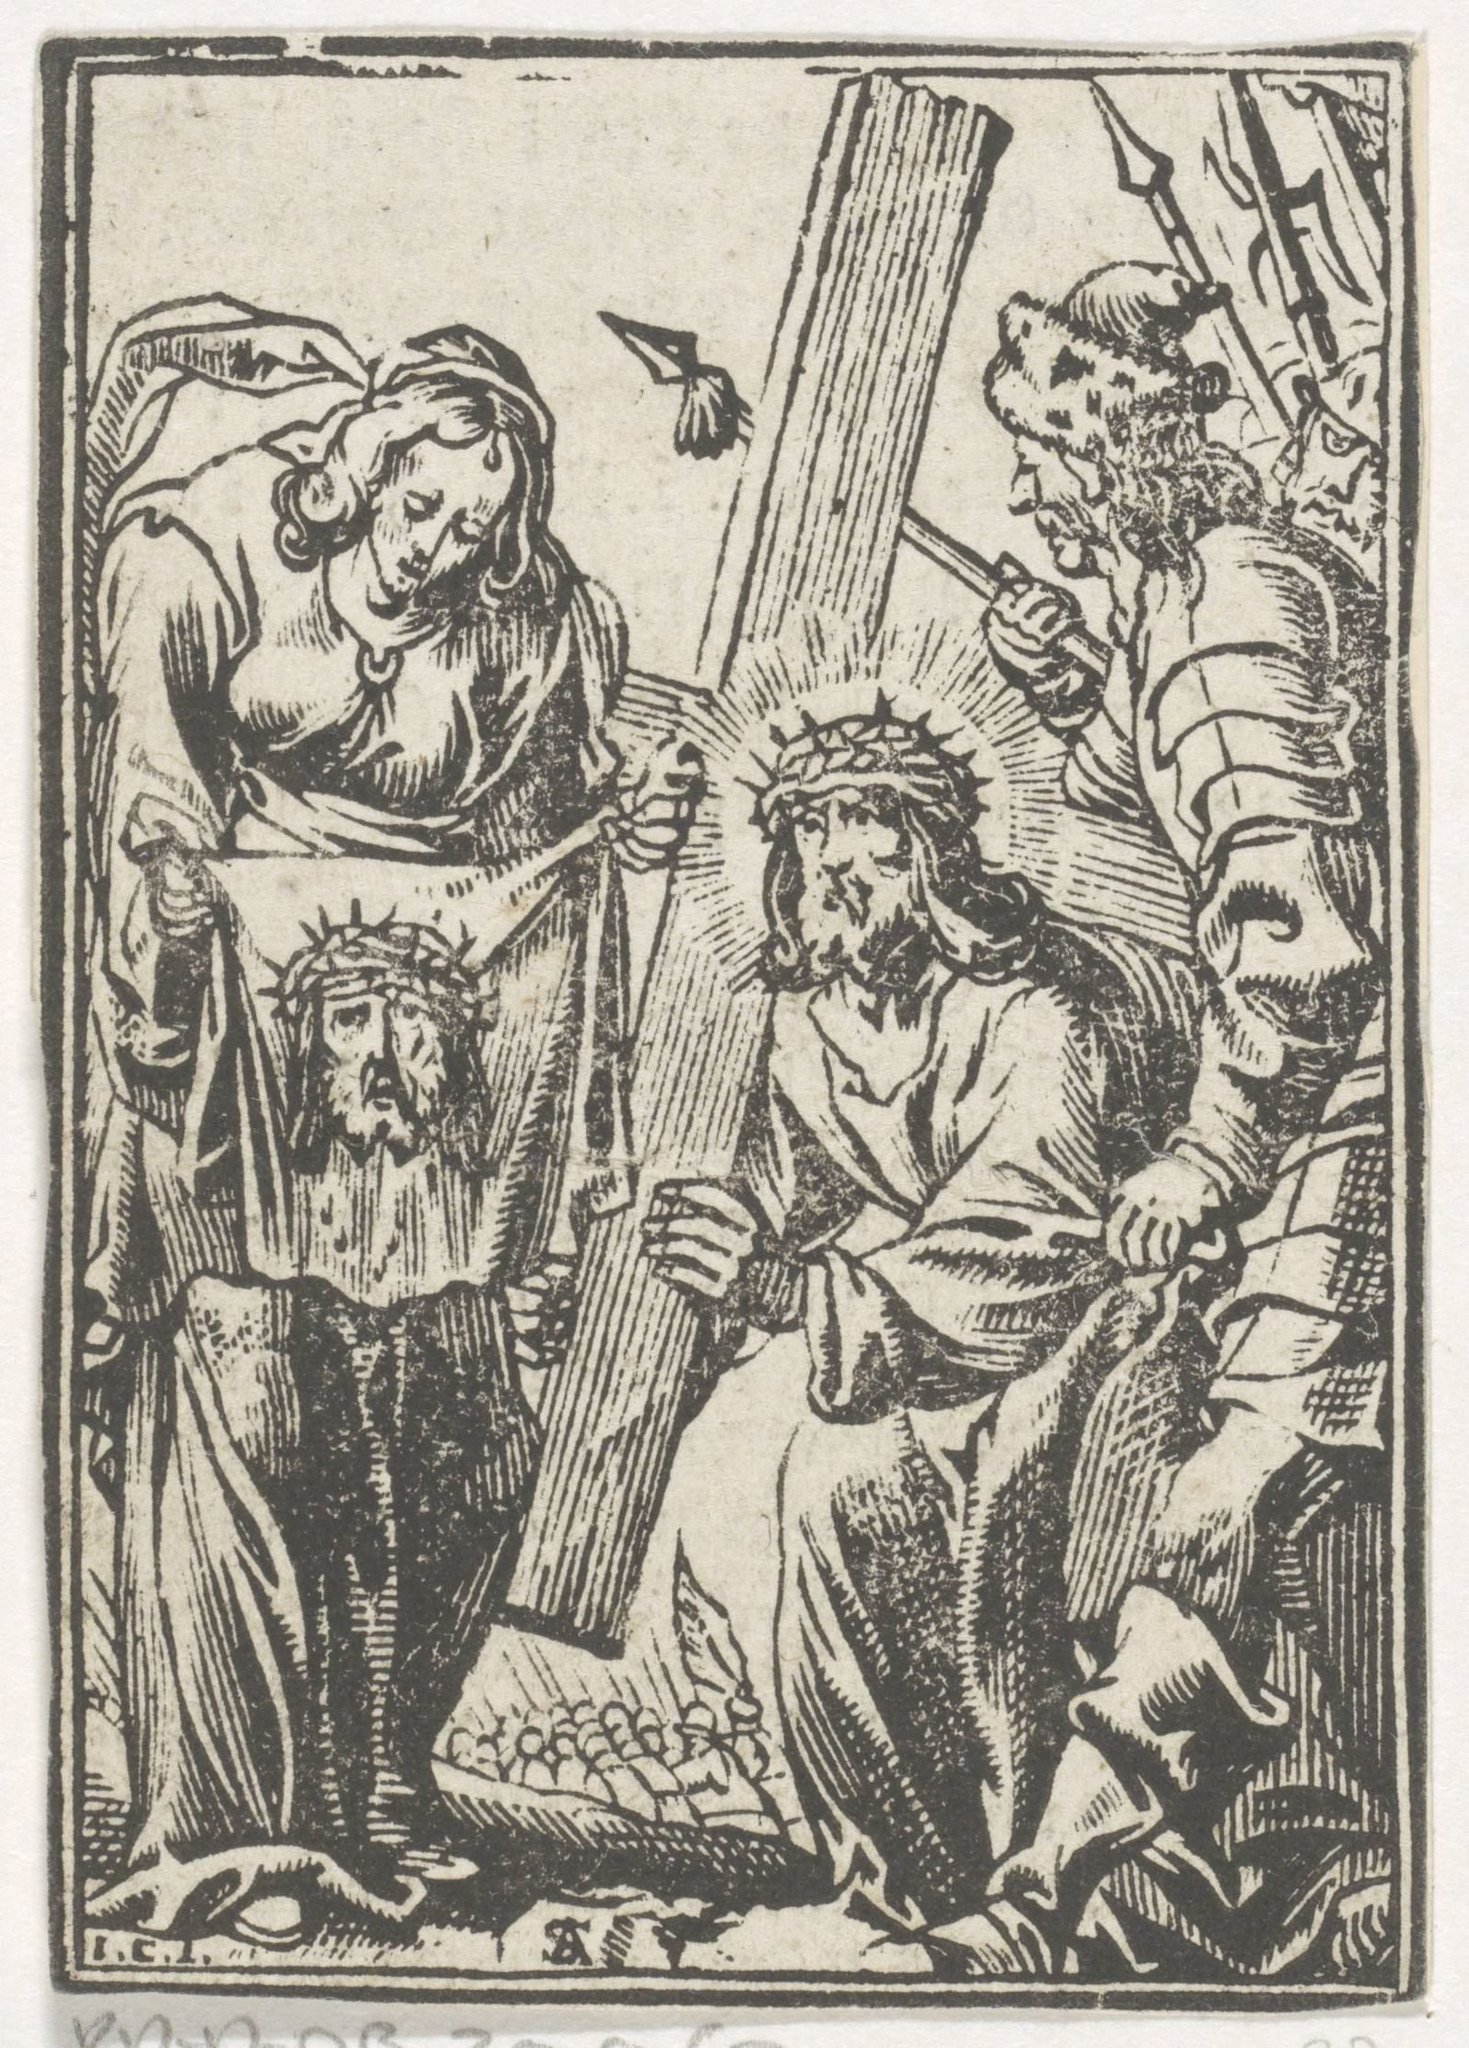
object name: print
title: Ontmoeting met Veronica tijdens de kruisdraging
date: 1649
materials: paper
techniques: letterpress printing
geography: antwerp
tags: christ meets veronica, who has a cloth to wipe christ's face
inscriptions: collector's mark: Lugt 2228, collector's mark: Lugt 240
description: Christus draagt het kruis en naast hem staat Veronica die hem de doek toont waarop de afdruk van zijn gelaat achterbleef.